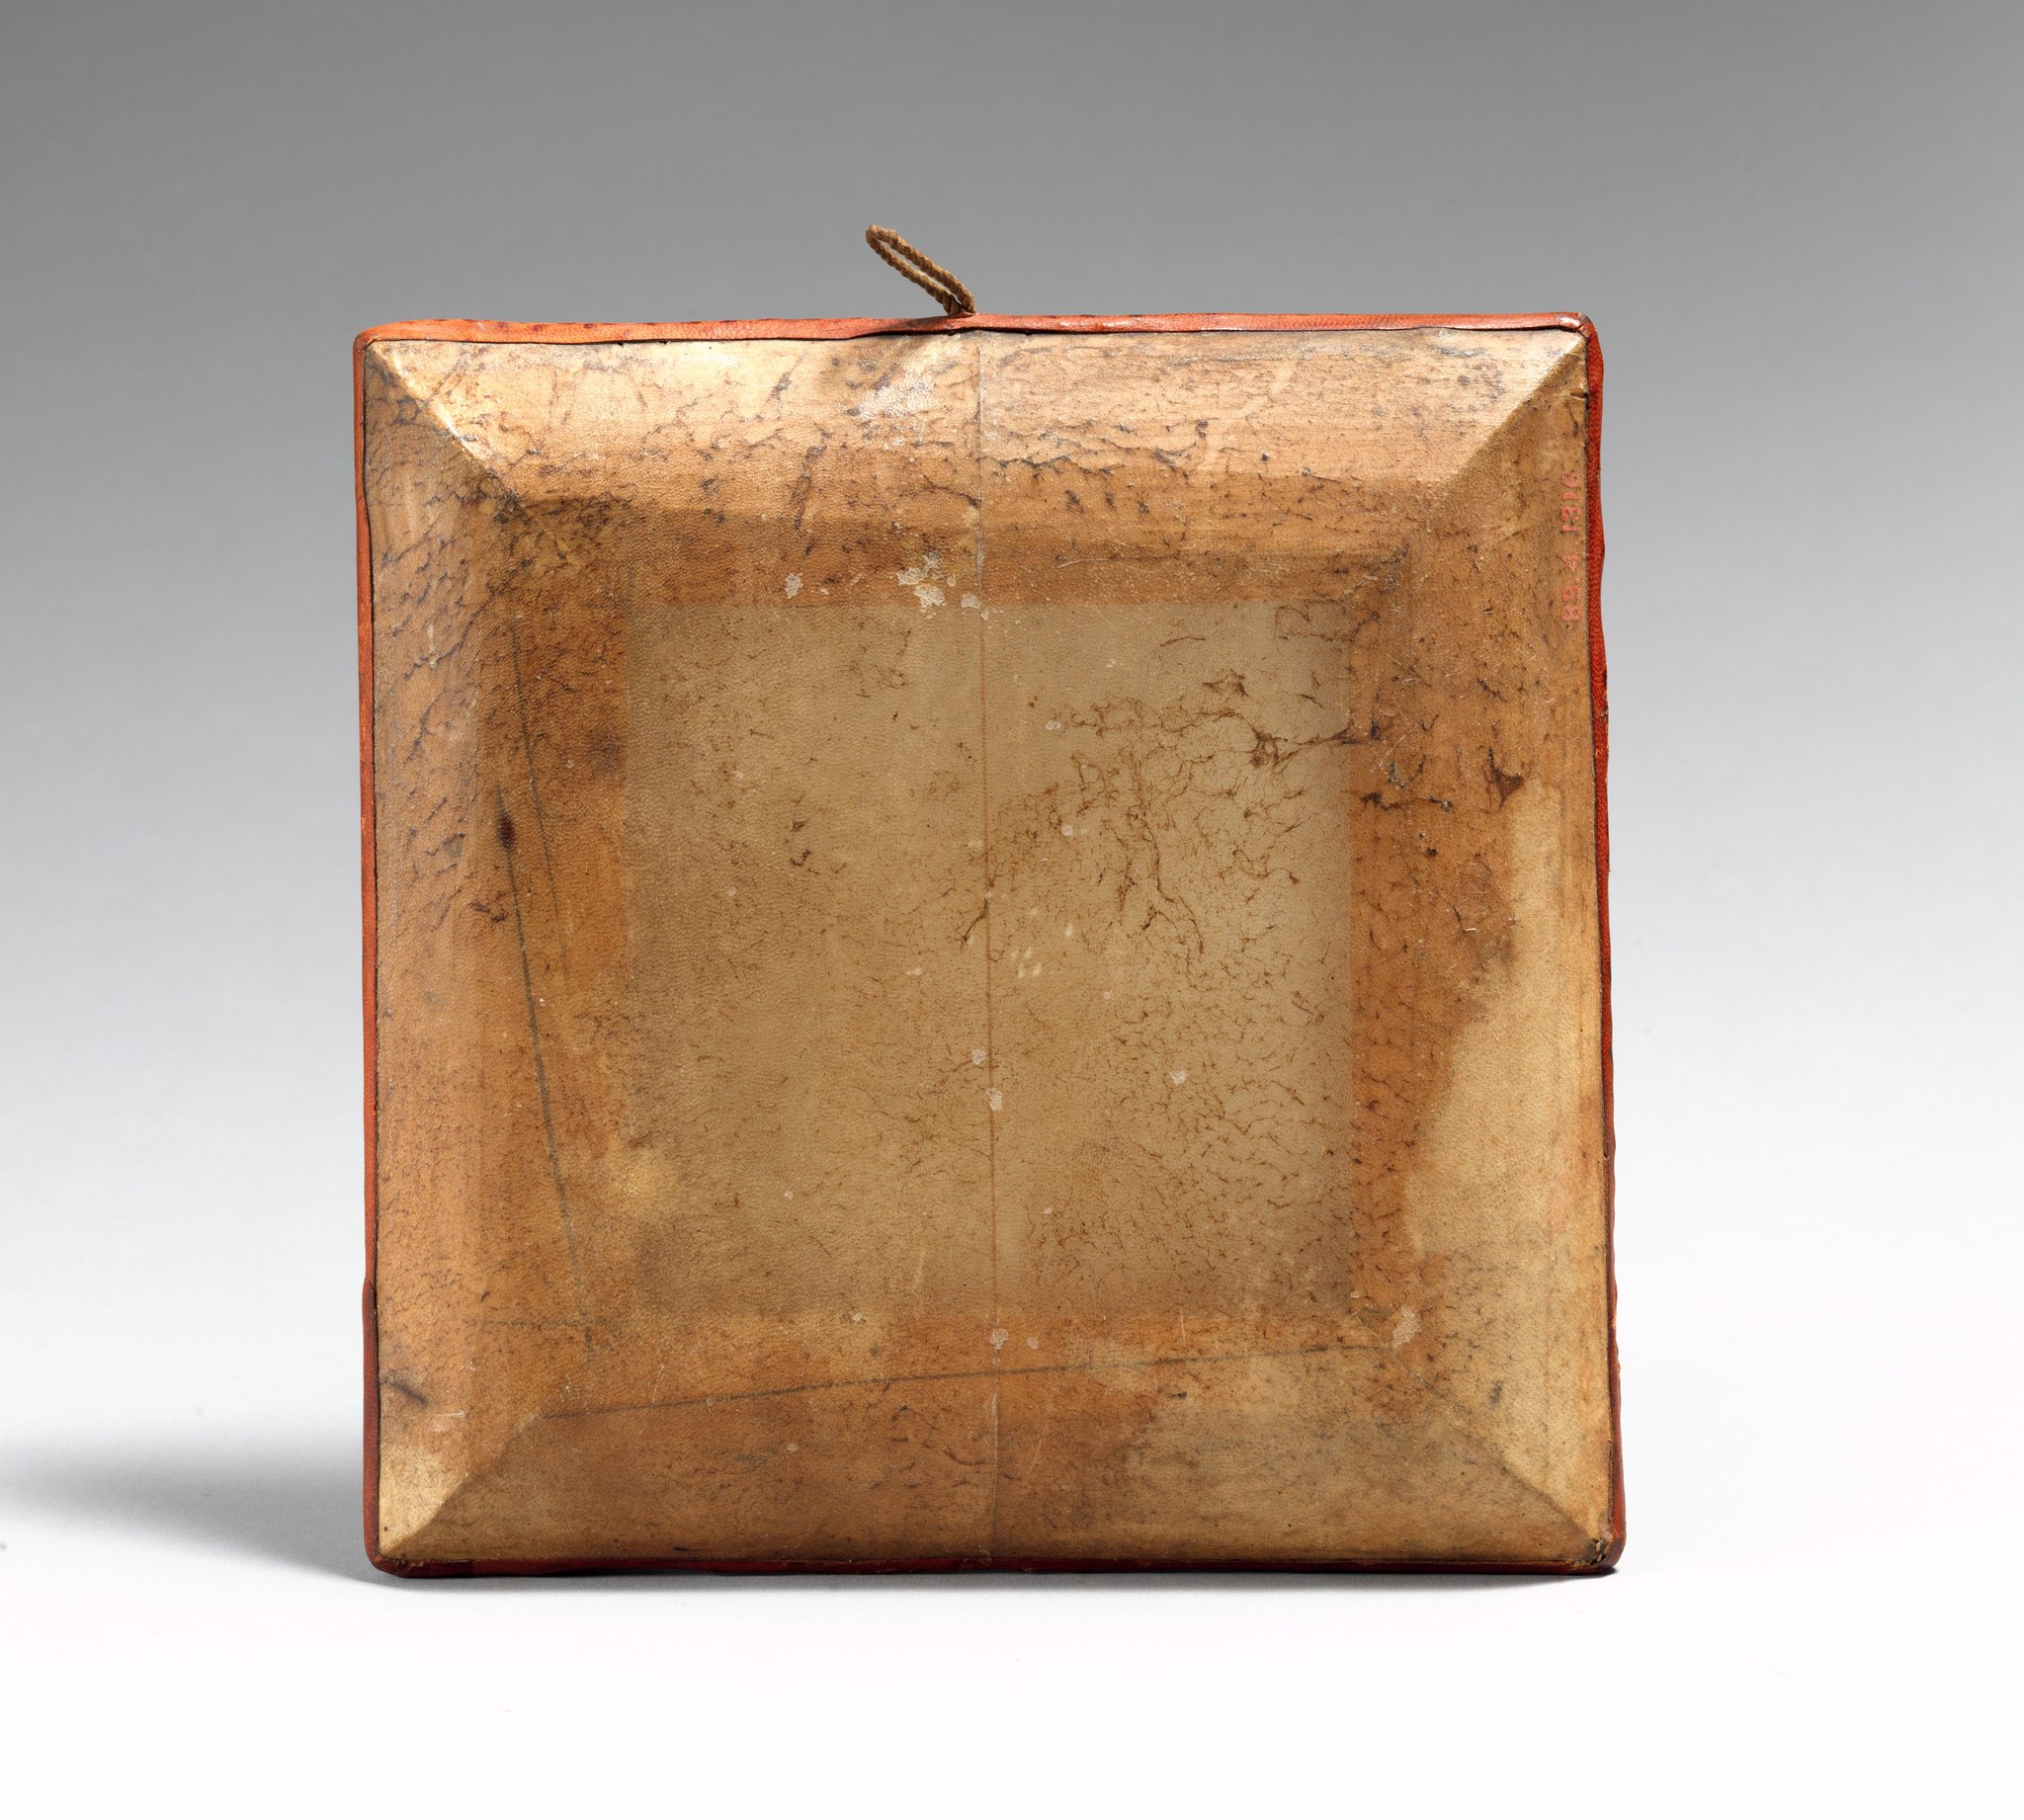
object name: deff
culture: algerian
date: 1801-1900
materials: skin, metal, wood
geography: algeria